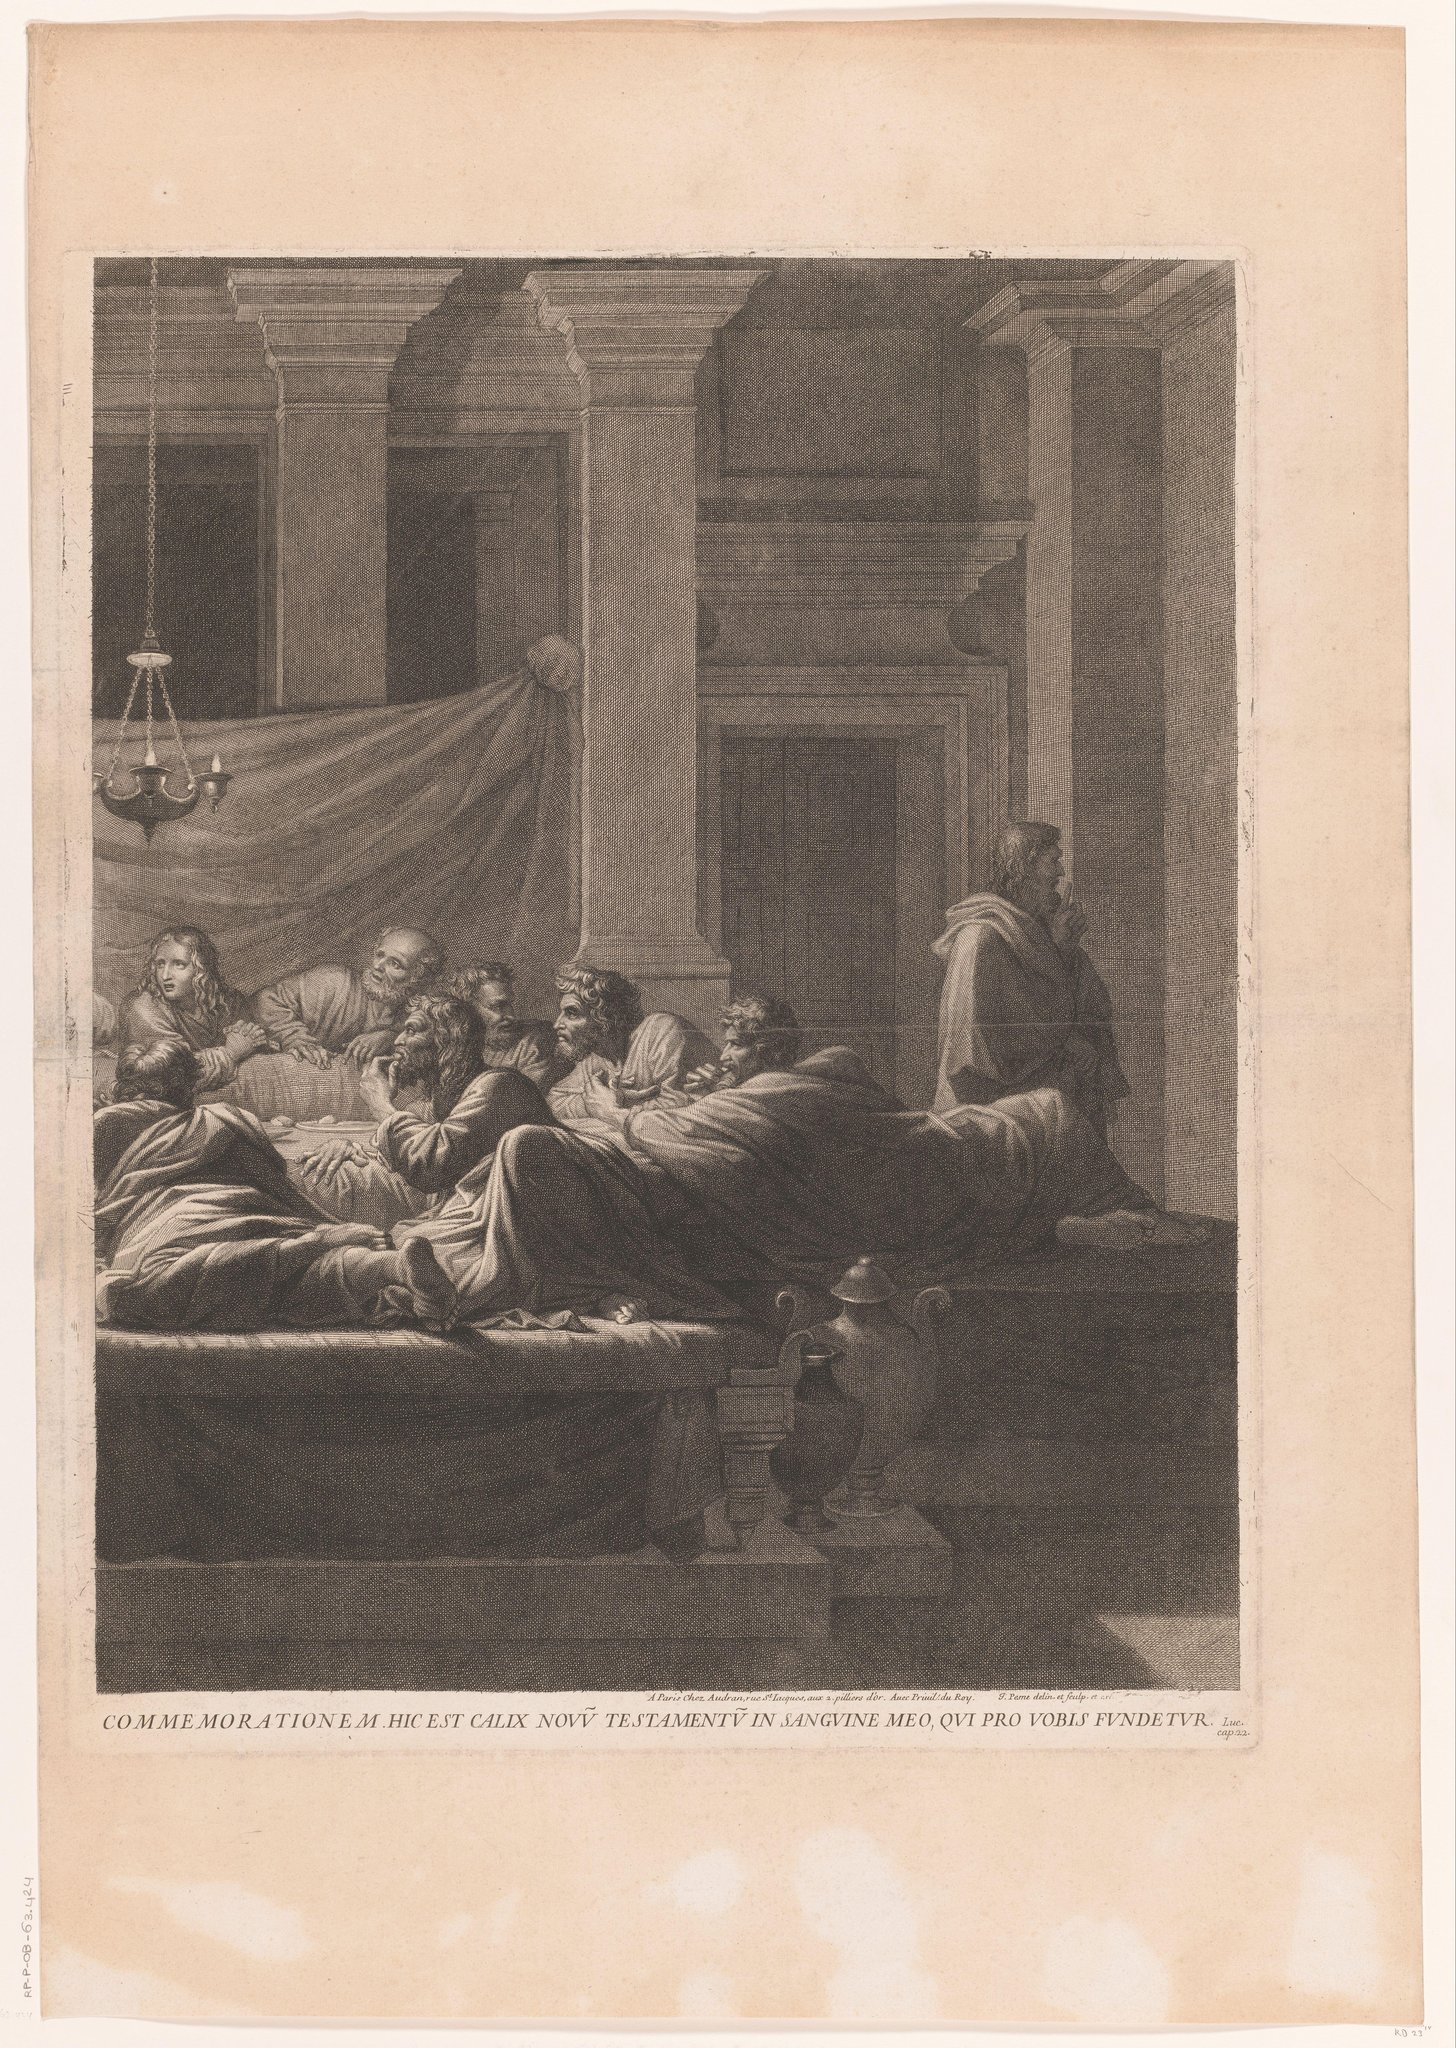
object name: print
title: Commemorationem hic est (...) vobis fundetur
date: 1680-1694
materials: paper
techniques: etching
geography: france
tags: the eucharist ~ the fourth of the seven sacraments, institution of the eucharist, i.e. christ showing or blessing bread (host) and/or wine (matthew 26:26-27; mark 14:22-23; luke 22:19-20; john 13:26; 1 corinthians 11:23-25)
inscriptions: collector's mark: Lugt 240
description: Prent maakt deel uit van een ongenummerde serie van zeven prenten.